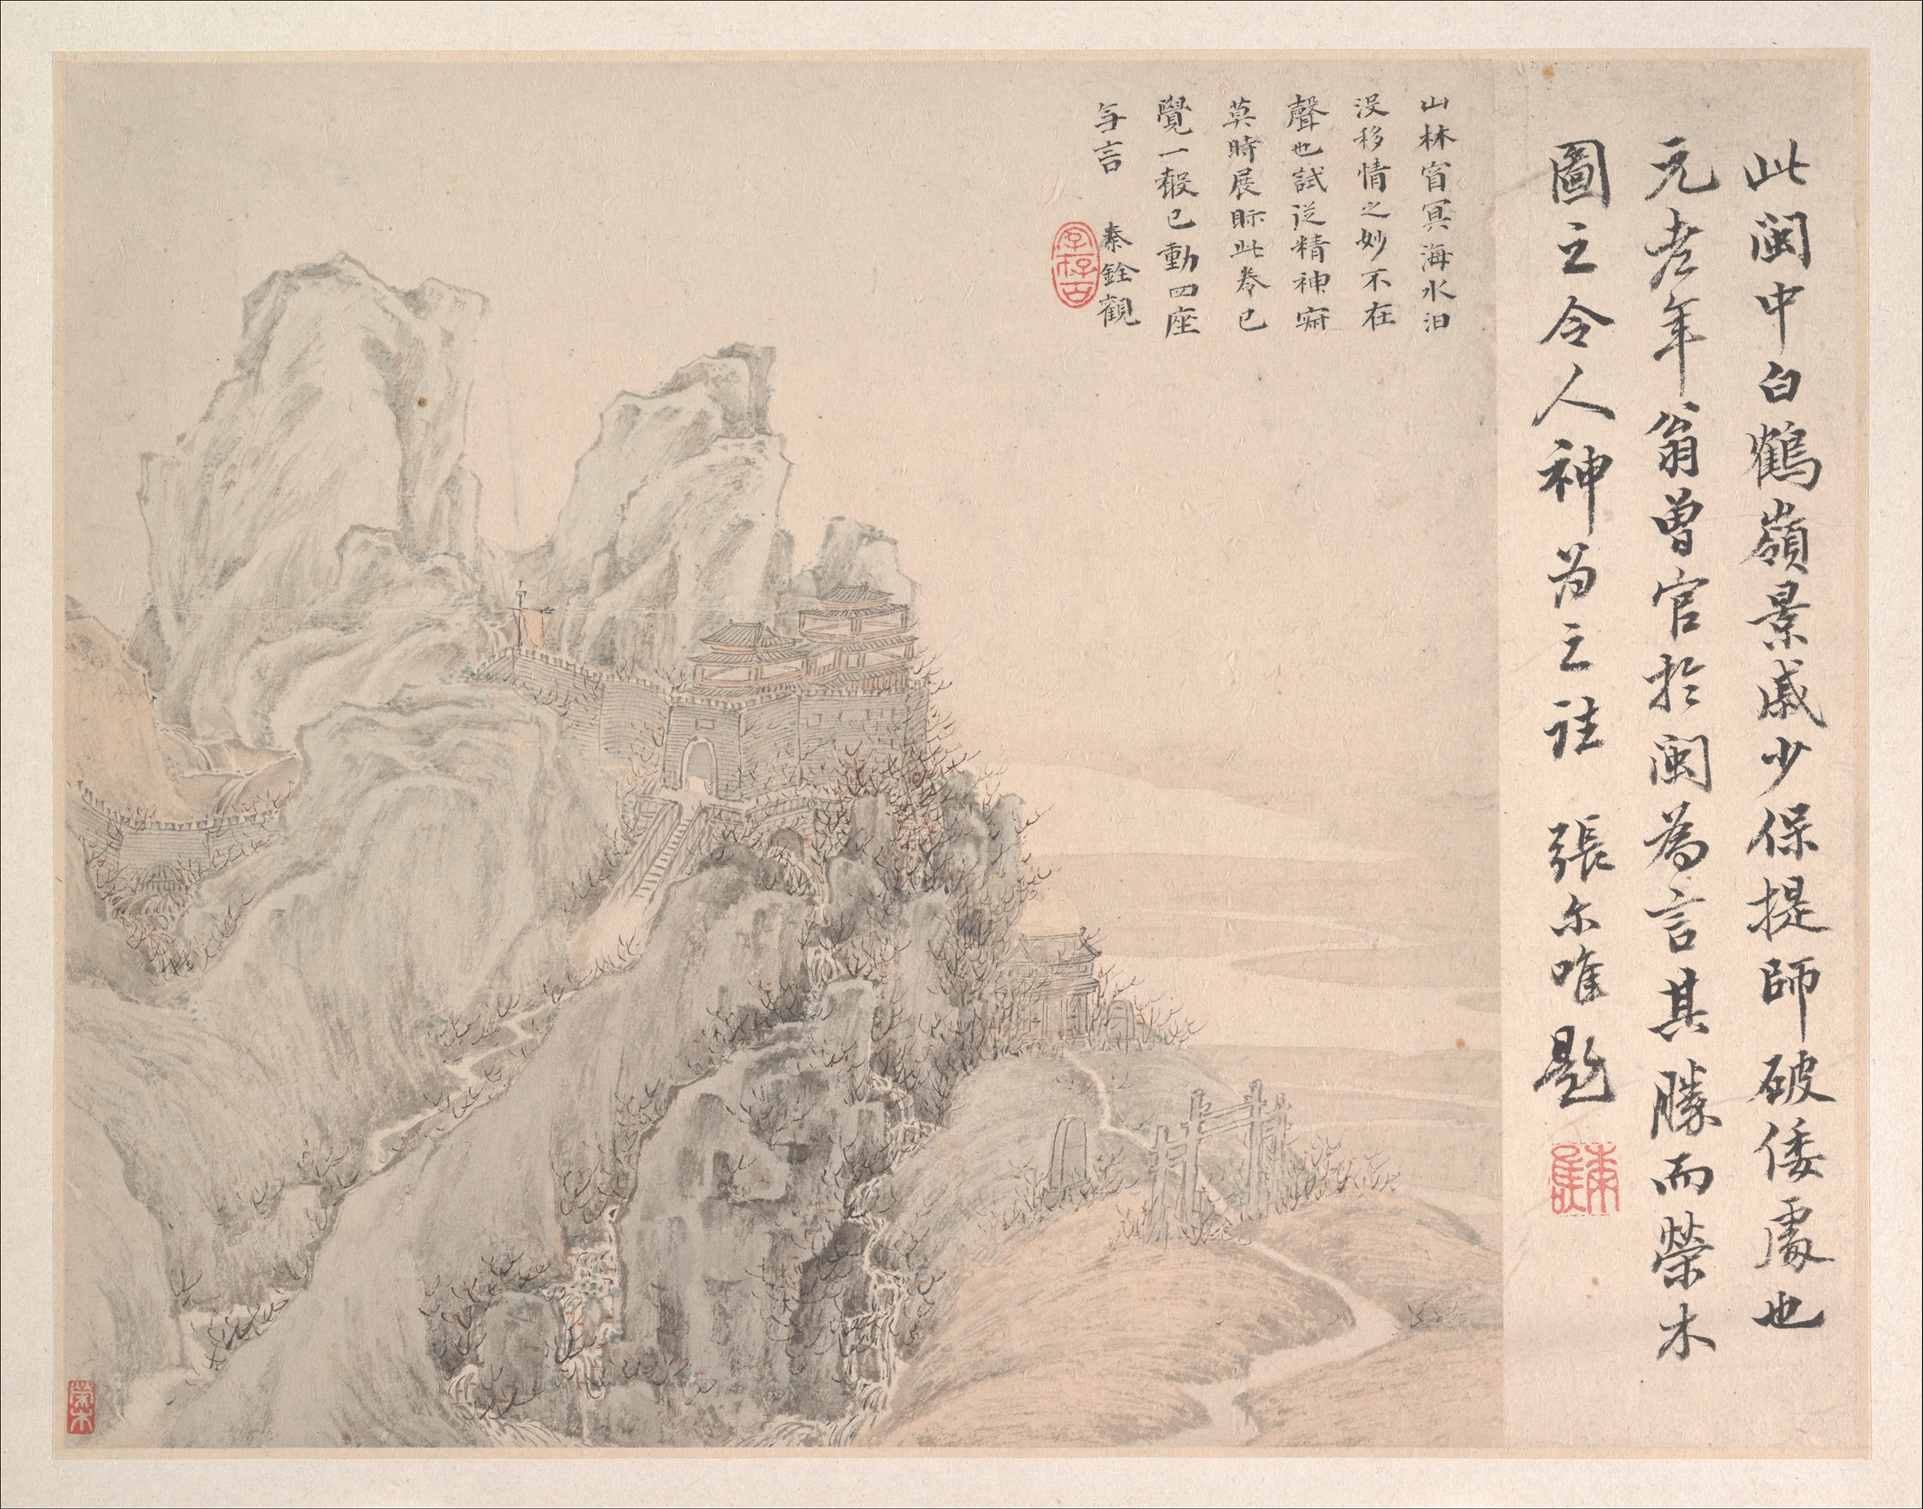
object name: album leaf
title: White Crane Mountain, leaf from Album for Zhou Lianggong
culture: chinese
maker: ye xin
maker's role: artist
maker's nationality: chinese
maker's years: 1640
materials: ink, paper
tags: mountains,landscapes